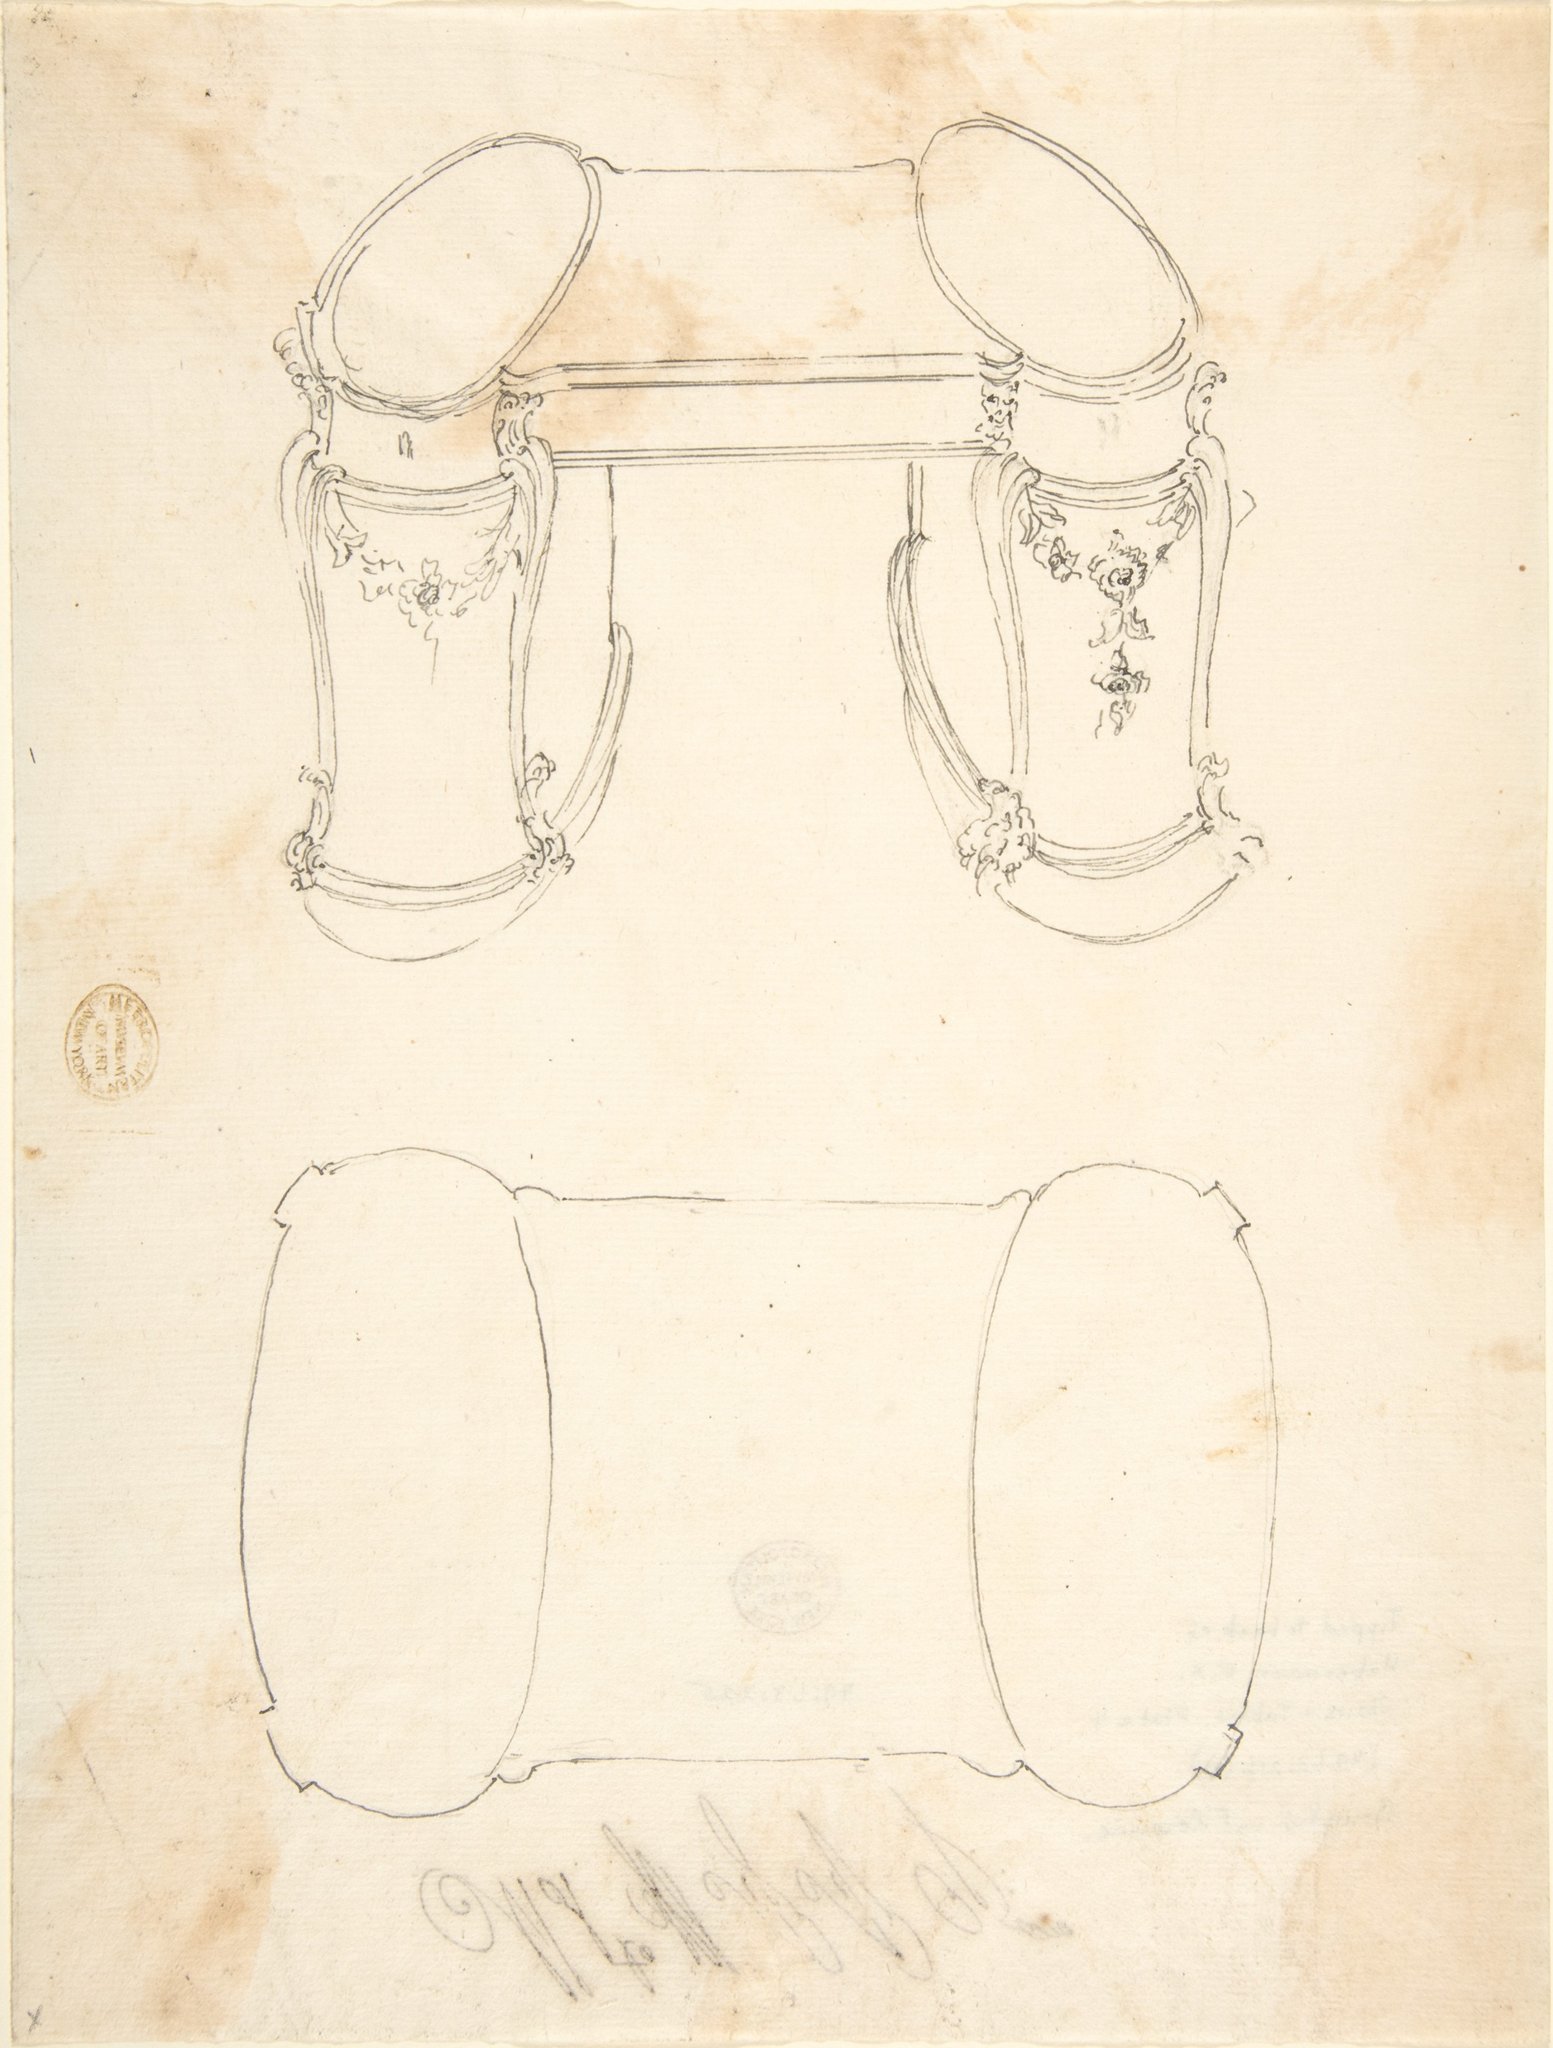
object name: drawing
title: Two Design Drawings for a Writing Desk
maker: anonymous, italian, 18th century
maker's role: artist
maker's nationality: italian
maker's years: 1700-1800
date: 1701-1800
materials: chalk, ink, paper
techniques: pen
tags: desks